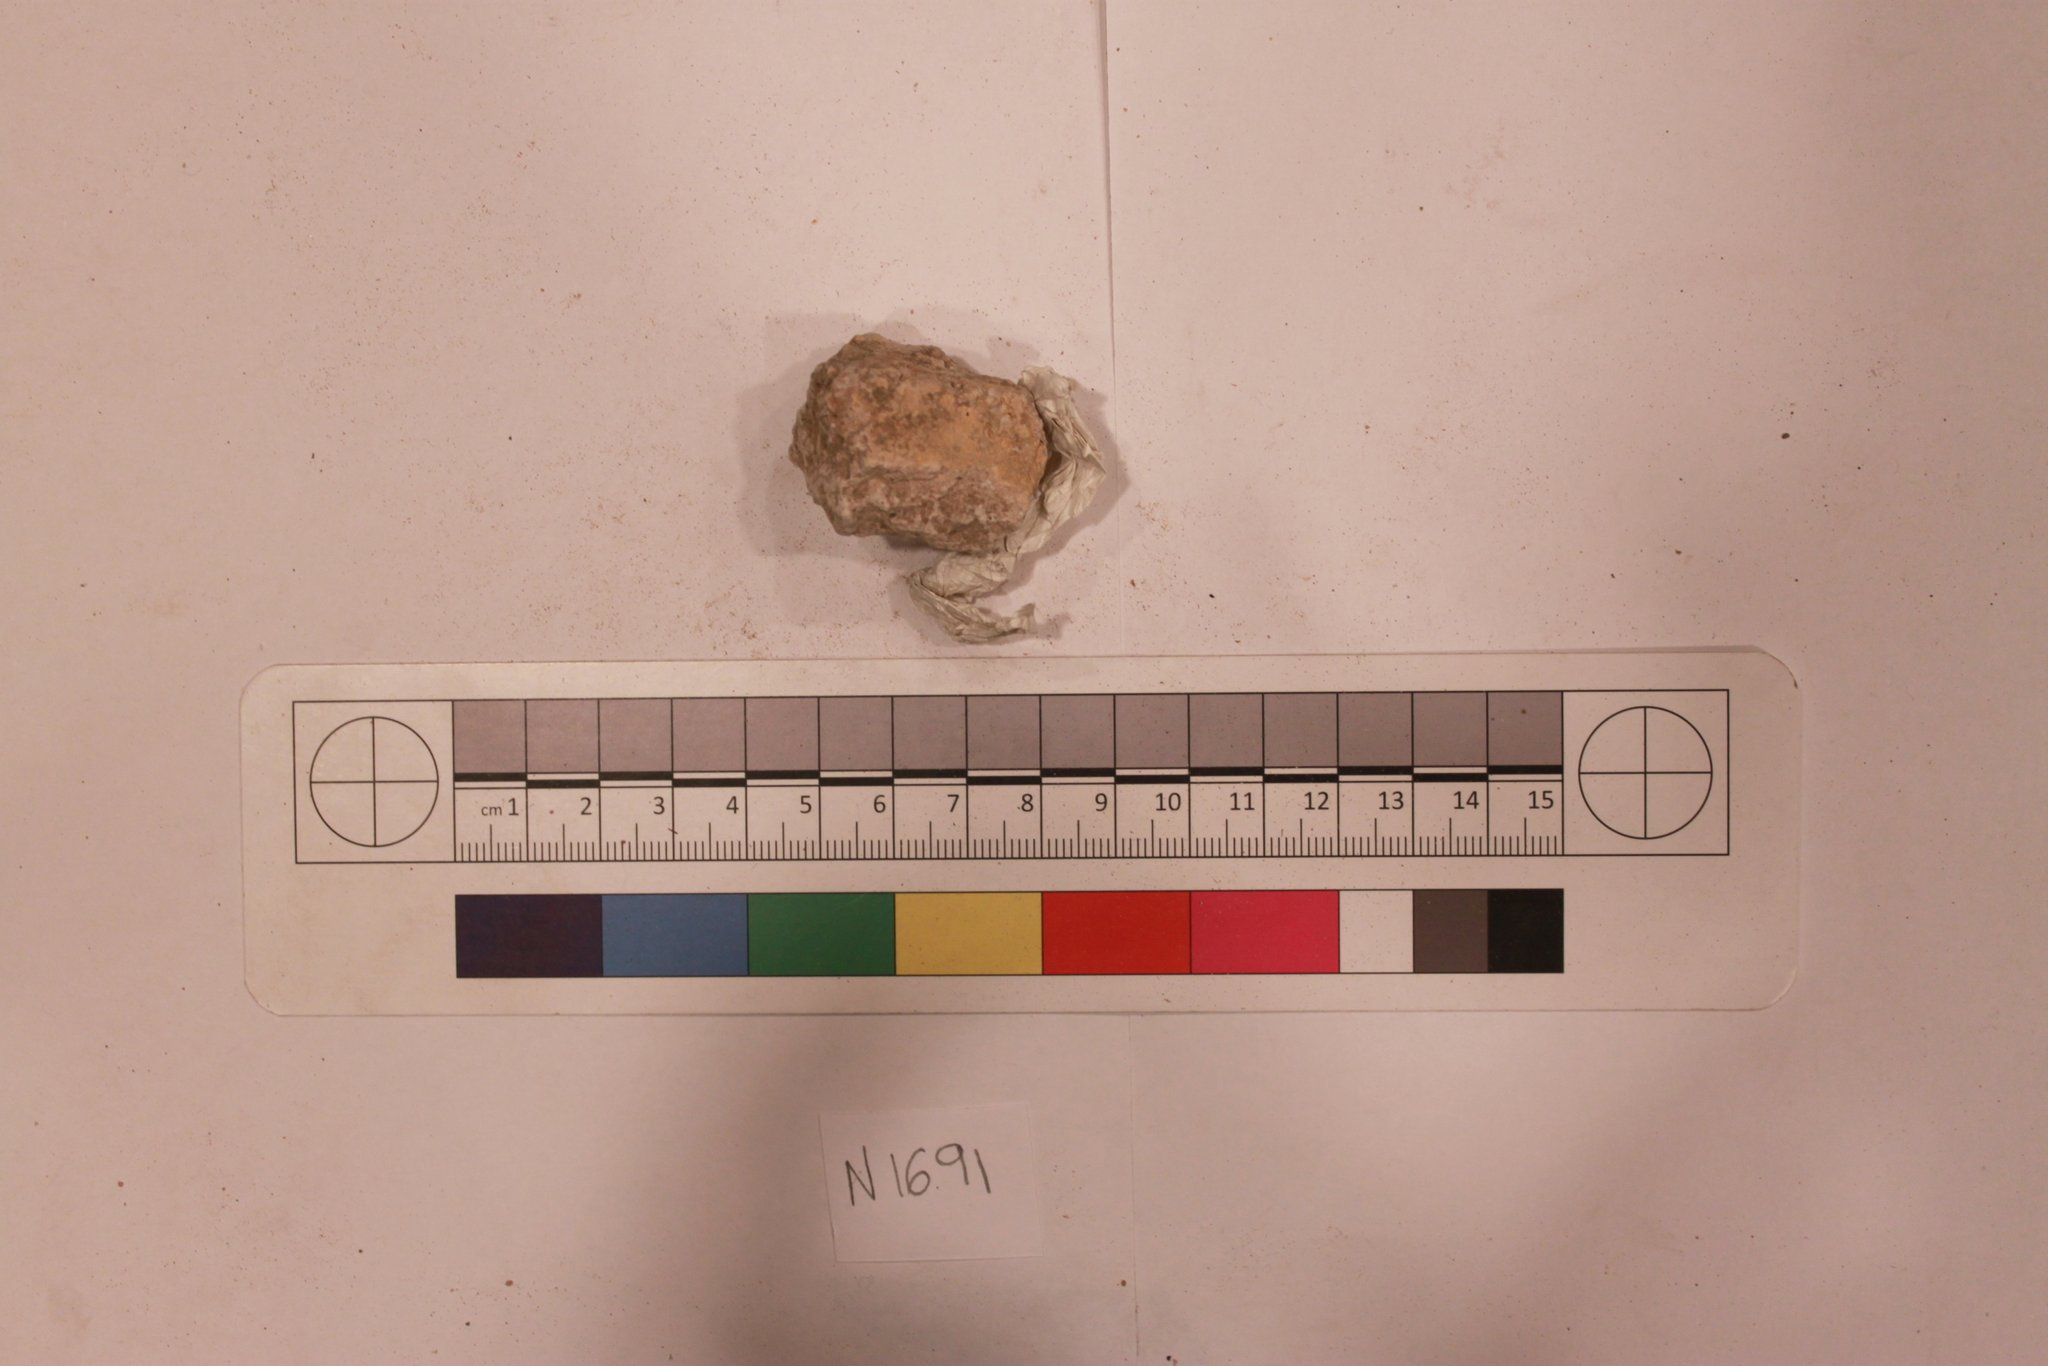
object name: fragment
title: Stucco Fragment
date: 701-1200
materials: plaster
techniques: carving, painting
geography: iran